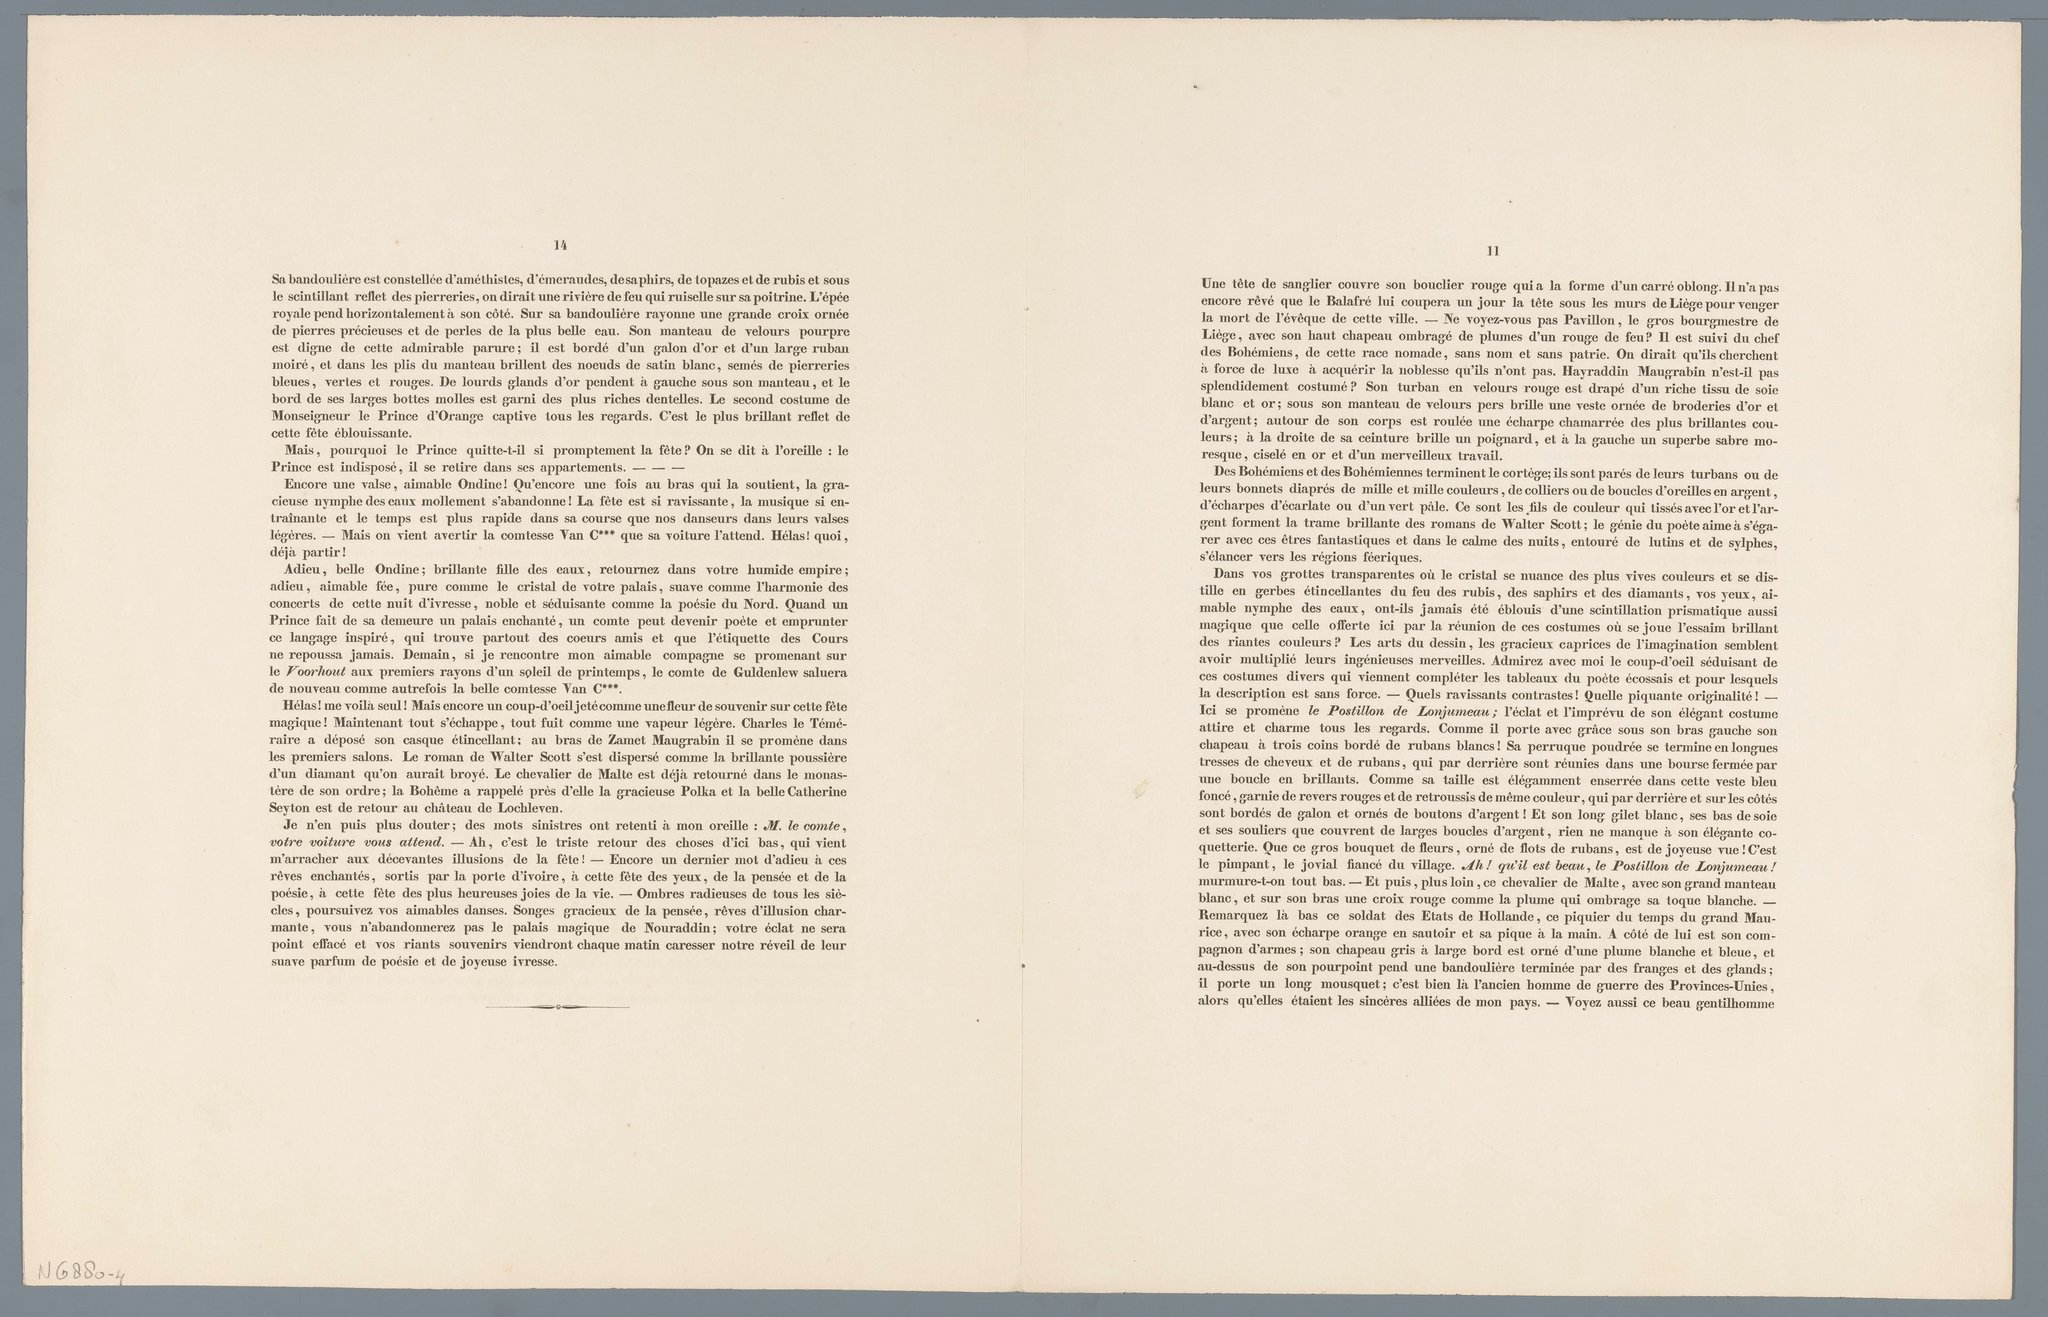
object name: text sheet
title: Tekst uit: Le Bal Costumé donné au Palais de S.A.R. Monseigneur le Prince d'Orange au 26 Fevrier 1845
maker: le comte de guldenlew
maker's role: schrijver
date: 1845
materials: paper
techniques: letterpress printing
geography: the hague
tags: brussels, willem iii (koning der nederlanden)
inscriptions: date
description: Tekst met een deel van de beschrijving van het gekostumeerd bal gehouden op het paleis van de prins van Oranje (de latere koning Willem III) in Den Haag op 26 februari 1845, p. 11-14.